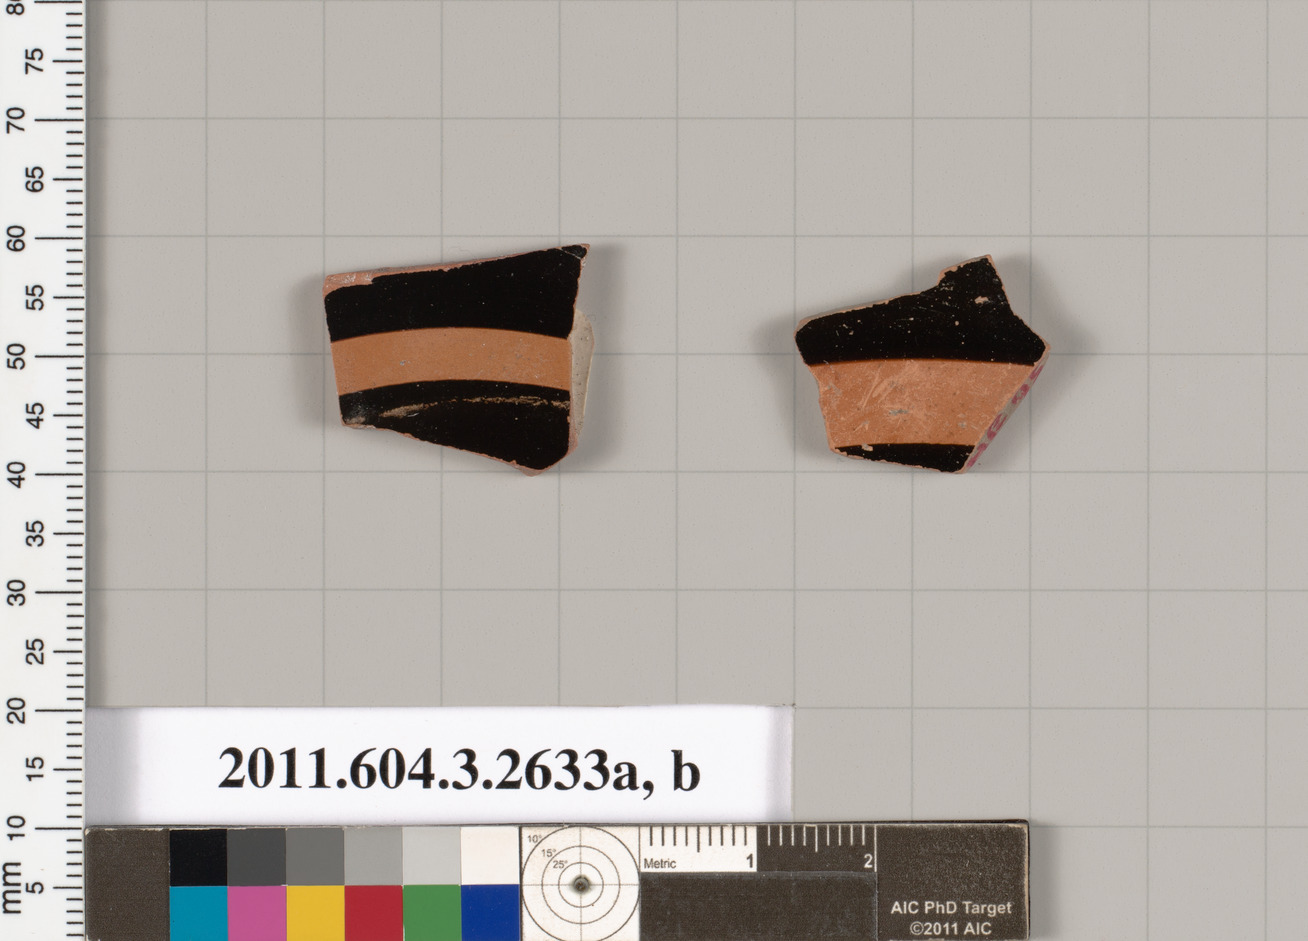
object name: kylix fragment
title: Terracotta fragments of kylikes (drinking cups)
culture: greek, attic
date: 600-401 BCE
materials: terracotta